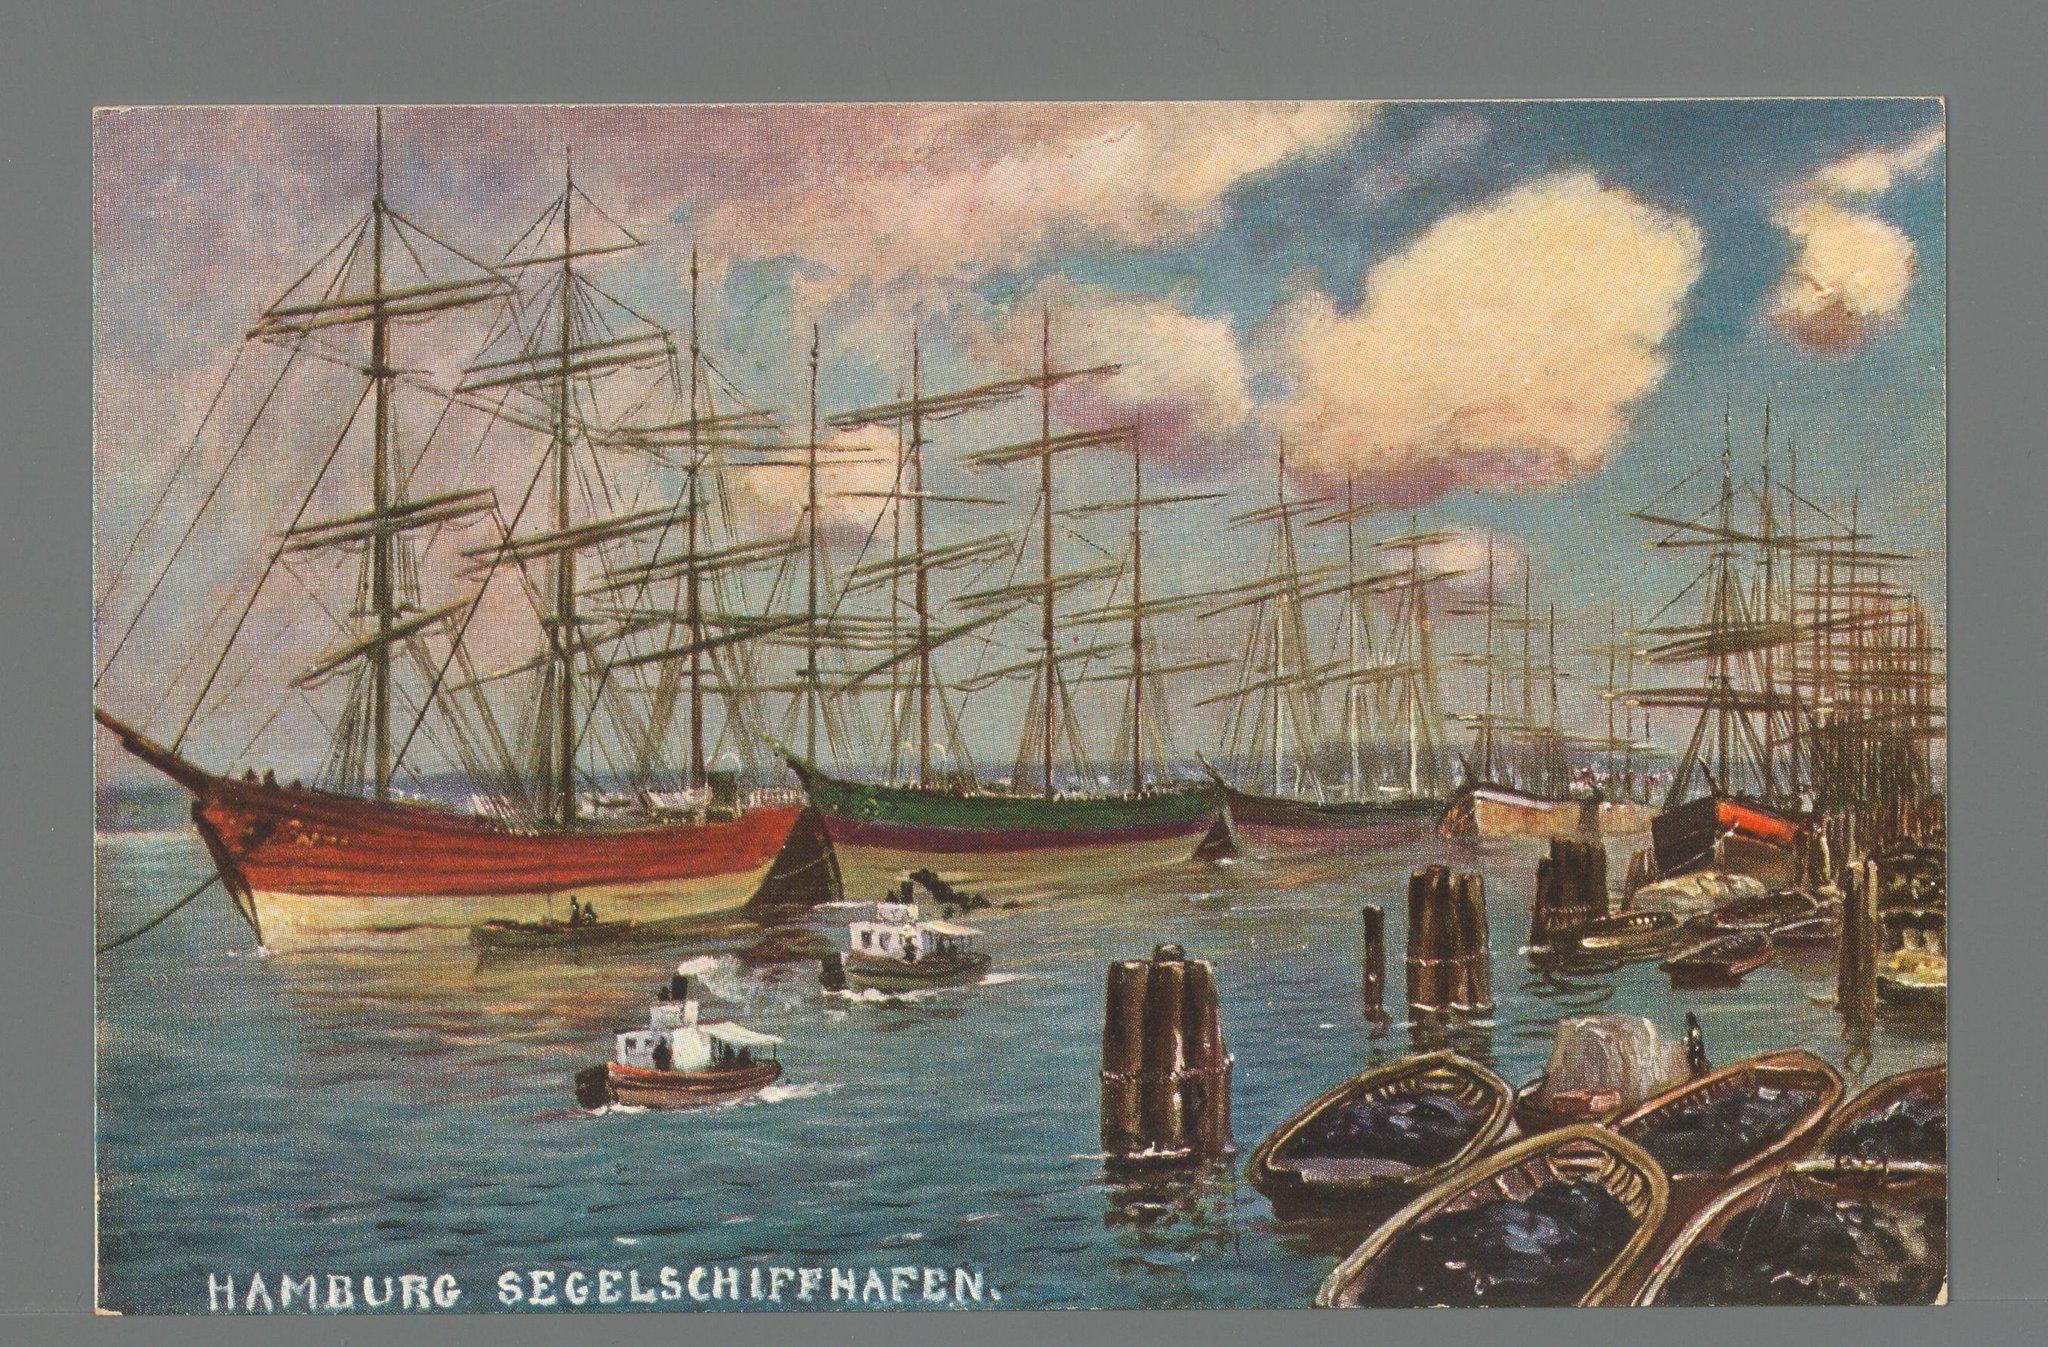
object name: photomechanical print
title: Hamburg. Segelschiffhafen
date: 1905-1930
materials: cardboard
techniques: color autotype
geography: nuremberg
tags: harbour, sailing-ship, sailing-boat